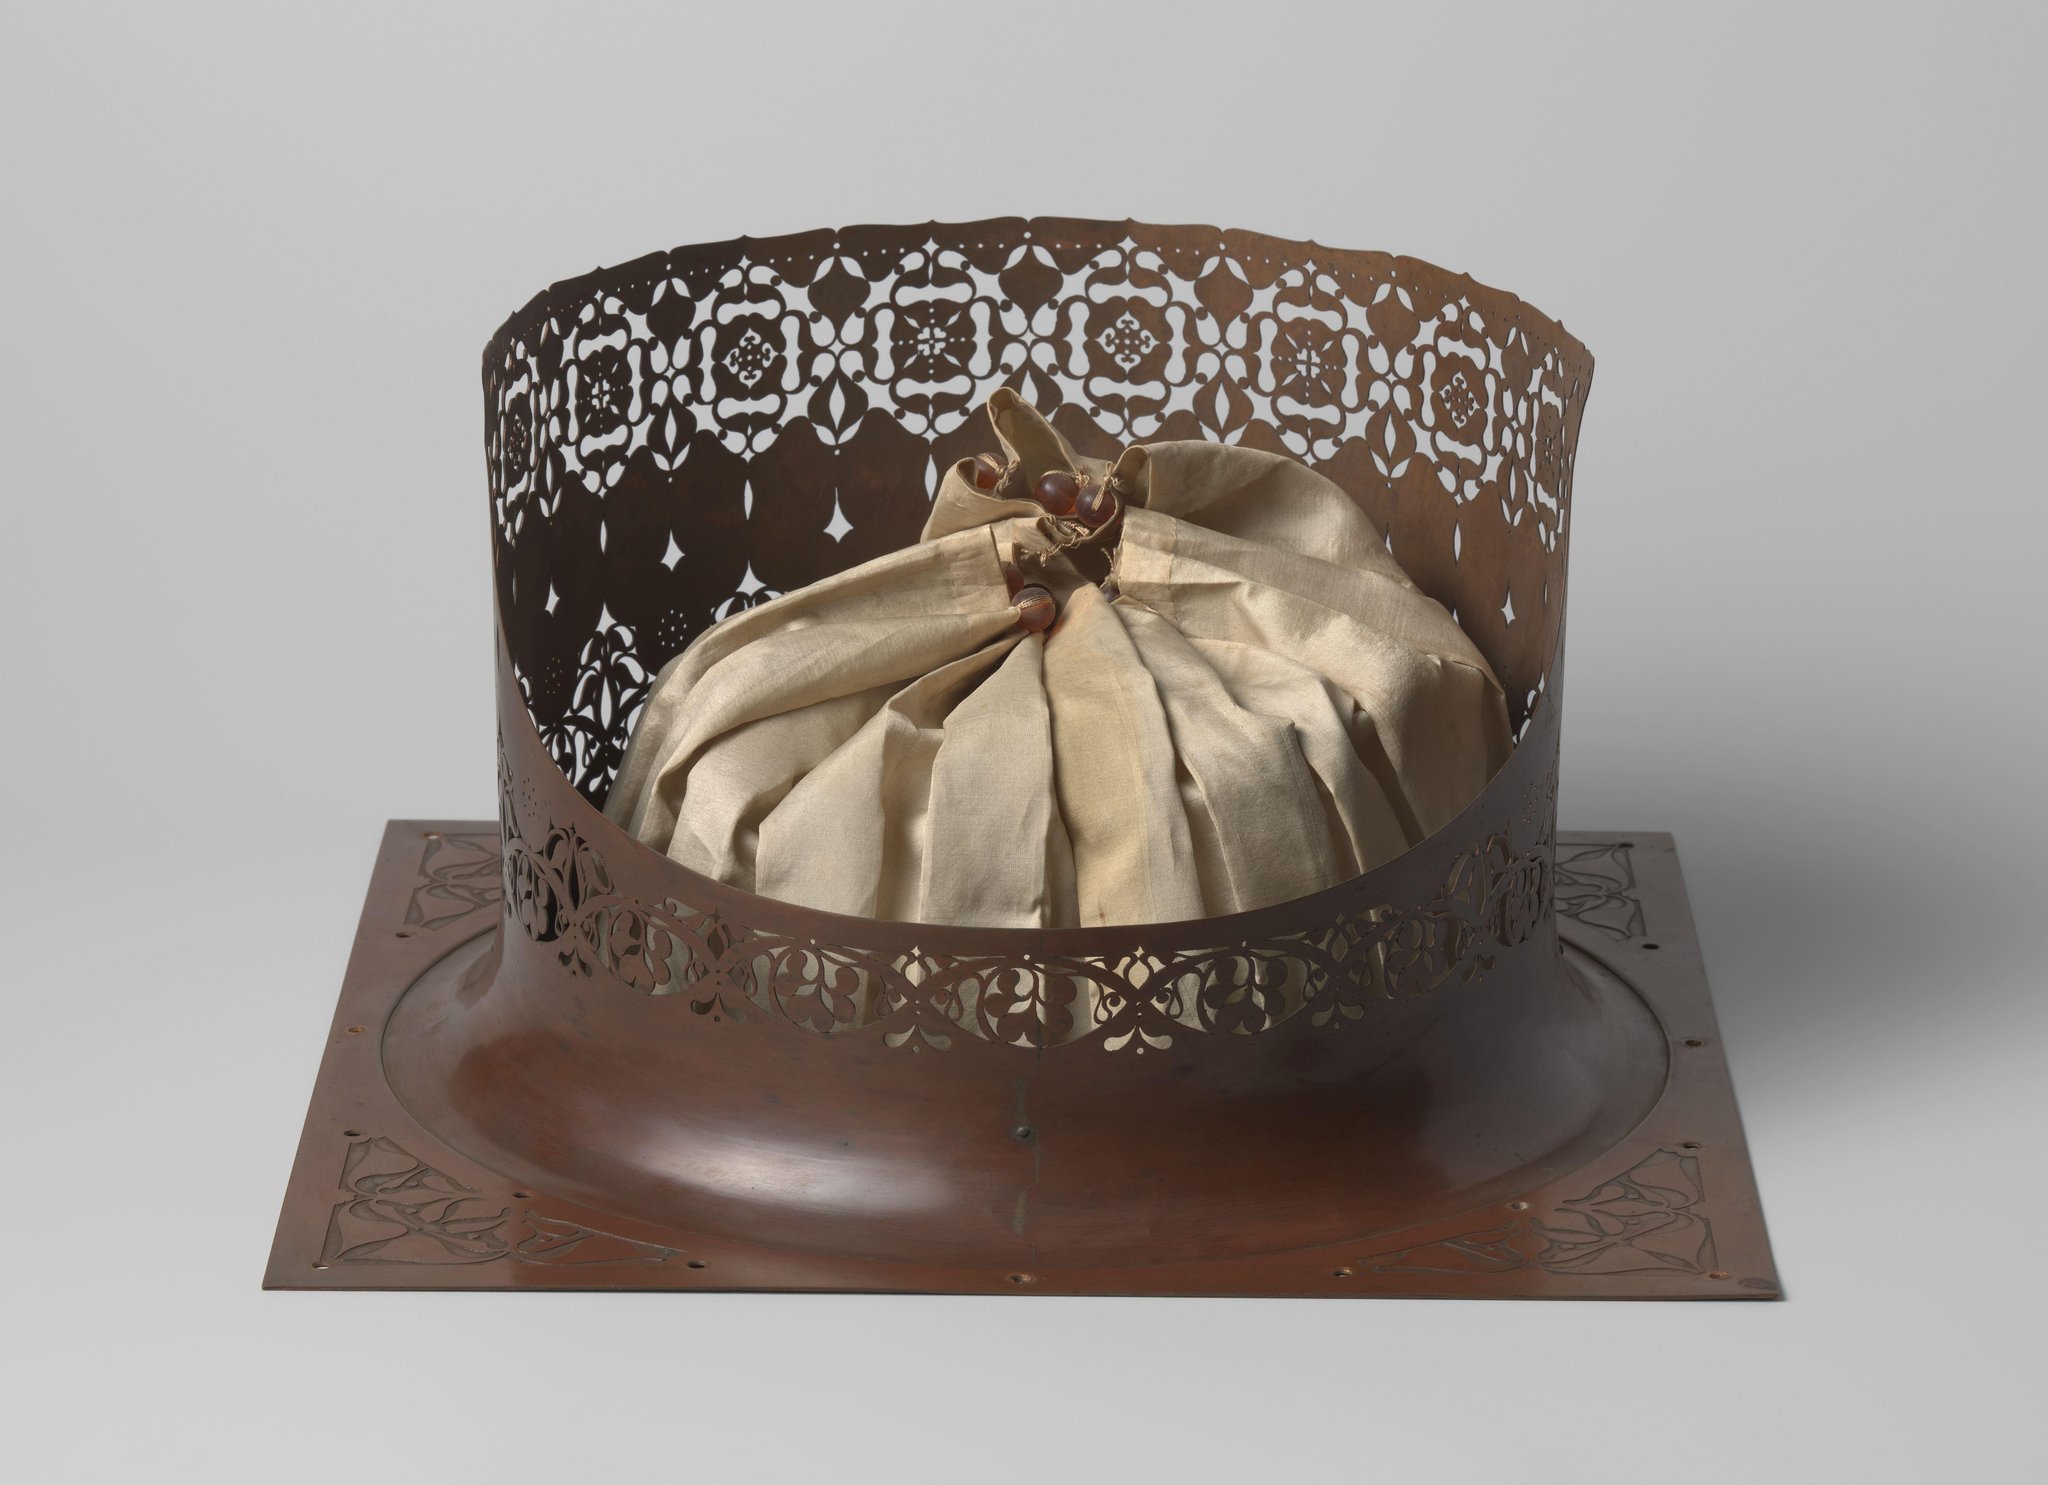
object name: ceiling fixture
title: Plafondlicht met ajourmotieven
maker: theo nieuwenhuis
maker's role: designer, draughtsman, print maker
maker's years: 1866-1951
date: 1916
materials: copper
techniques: embroidery, sawing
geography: amsterdam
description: Het licht bestaat uit een vierkante aanzet bij het plafond, welke naar het midden naar beneden toe rond ombuigt tot een ronde met twee rijen geometrische ajourmotieven gedecoreerde rand, welke aan één zijde halfrond is uitgezaagd. Tegen deze rand is ca. 1980 aan de binnenzijde een crèmekleurige met bruine kralen versierde volant van shantung aangebracht.